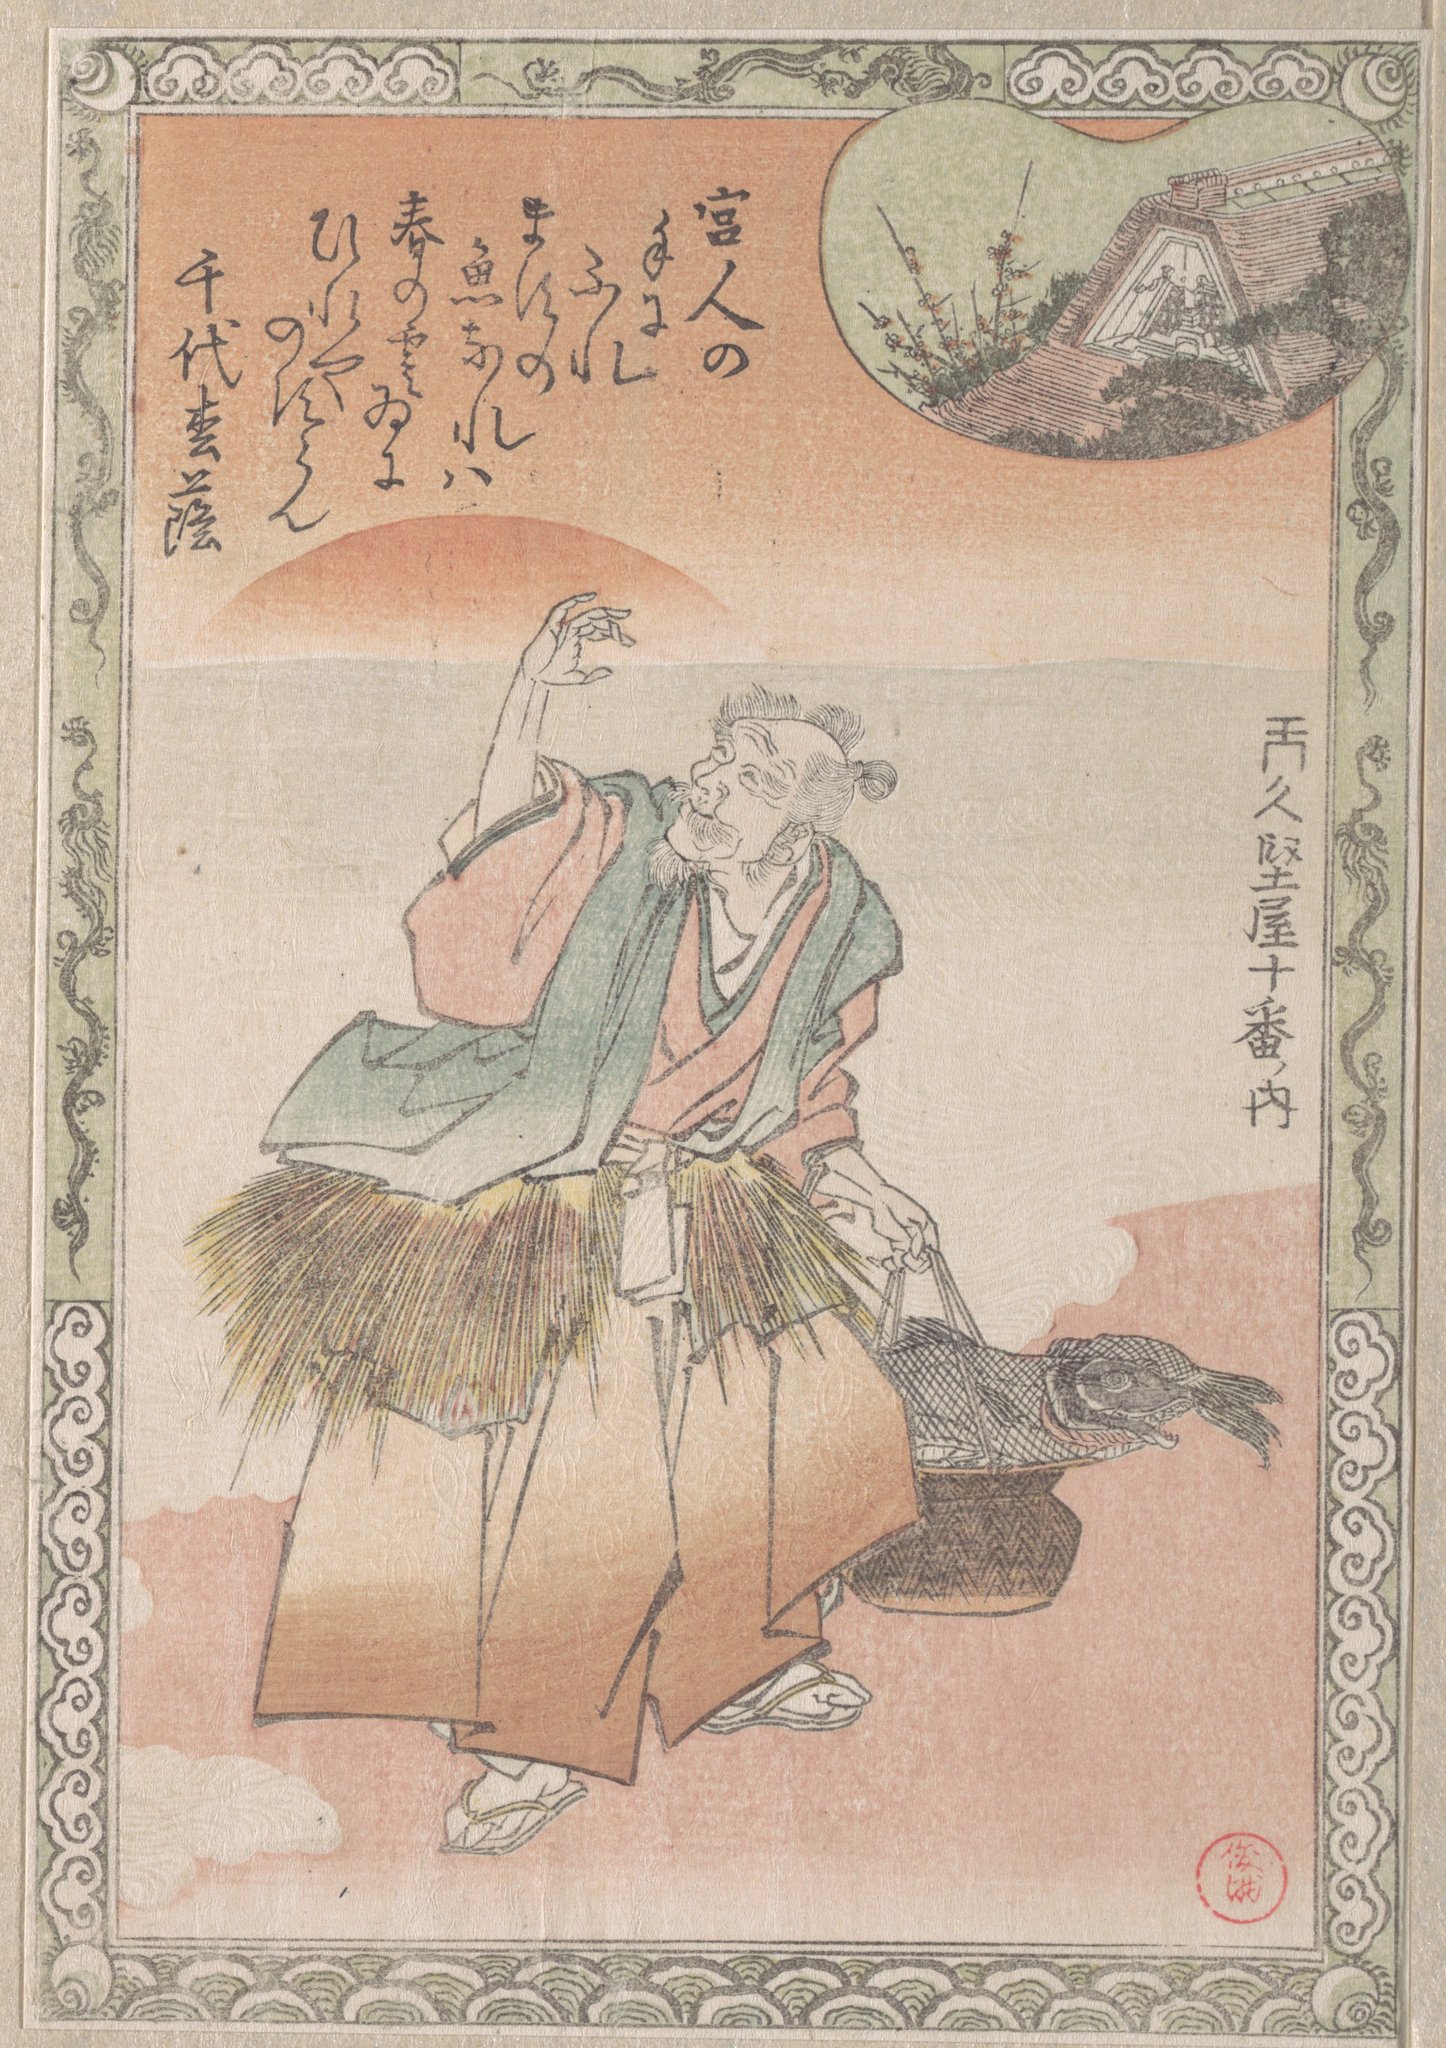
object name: woodblock print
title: Old Fisherman Carrying a Basket of Salmon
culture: japanese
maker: kubo shunman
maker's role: artist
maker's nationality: japanese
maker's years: 1757-1820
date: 1801-1900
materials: ink, paper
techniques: surimono, woodblock print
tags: men,fish